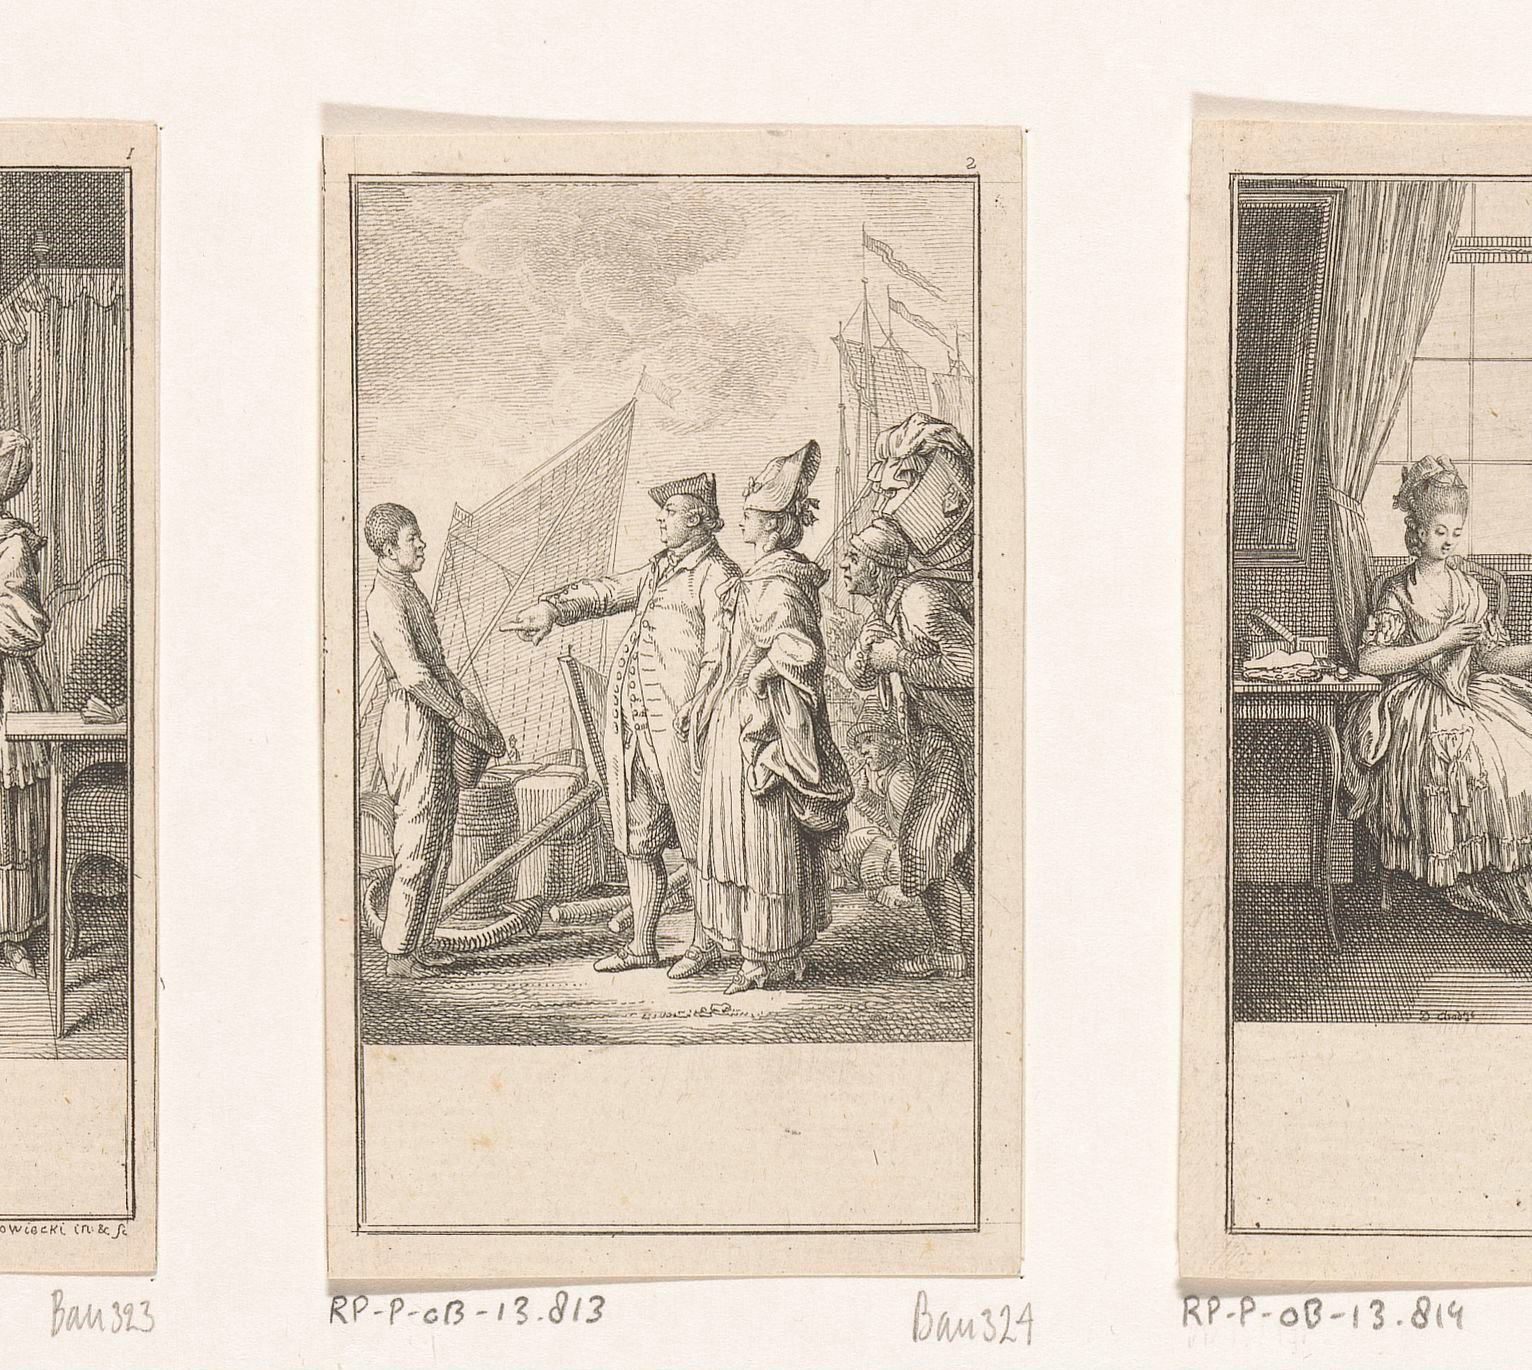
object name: print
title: Sophie en kapitein Puff van Vlieten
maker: daniel nikolaus chodowiecki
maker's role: draughtsman, print maker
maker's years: 1726-1801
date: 1777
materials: paper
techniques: etching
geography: berlin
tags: harbour, literature, porter, bearer, seaman: sailor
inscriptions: collector's mark: Lugt 2228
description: In Königsberg heeft kapitein Puff van Vlieten zich ontfermd over Sophie. In de haven geeft hij een opdracht aan zijn scheepsjongen Cornelius. Achter Sophie en de kapitein staat een drager, waarschijnlijk met de kostbaarheden van Herr Less op zijn rug. Rechtsboven genummerd: 2.